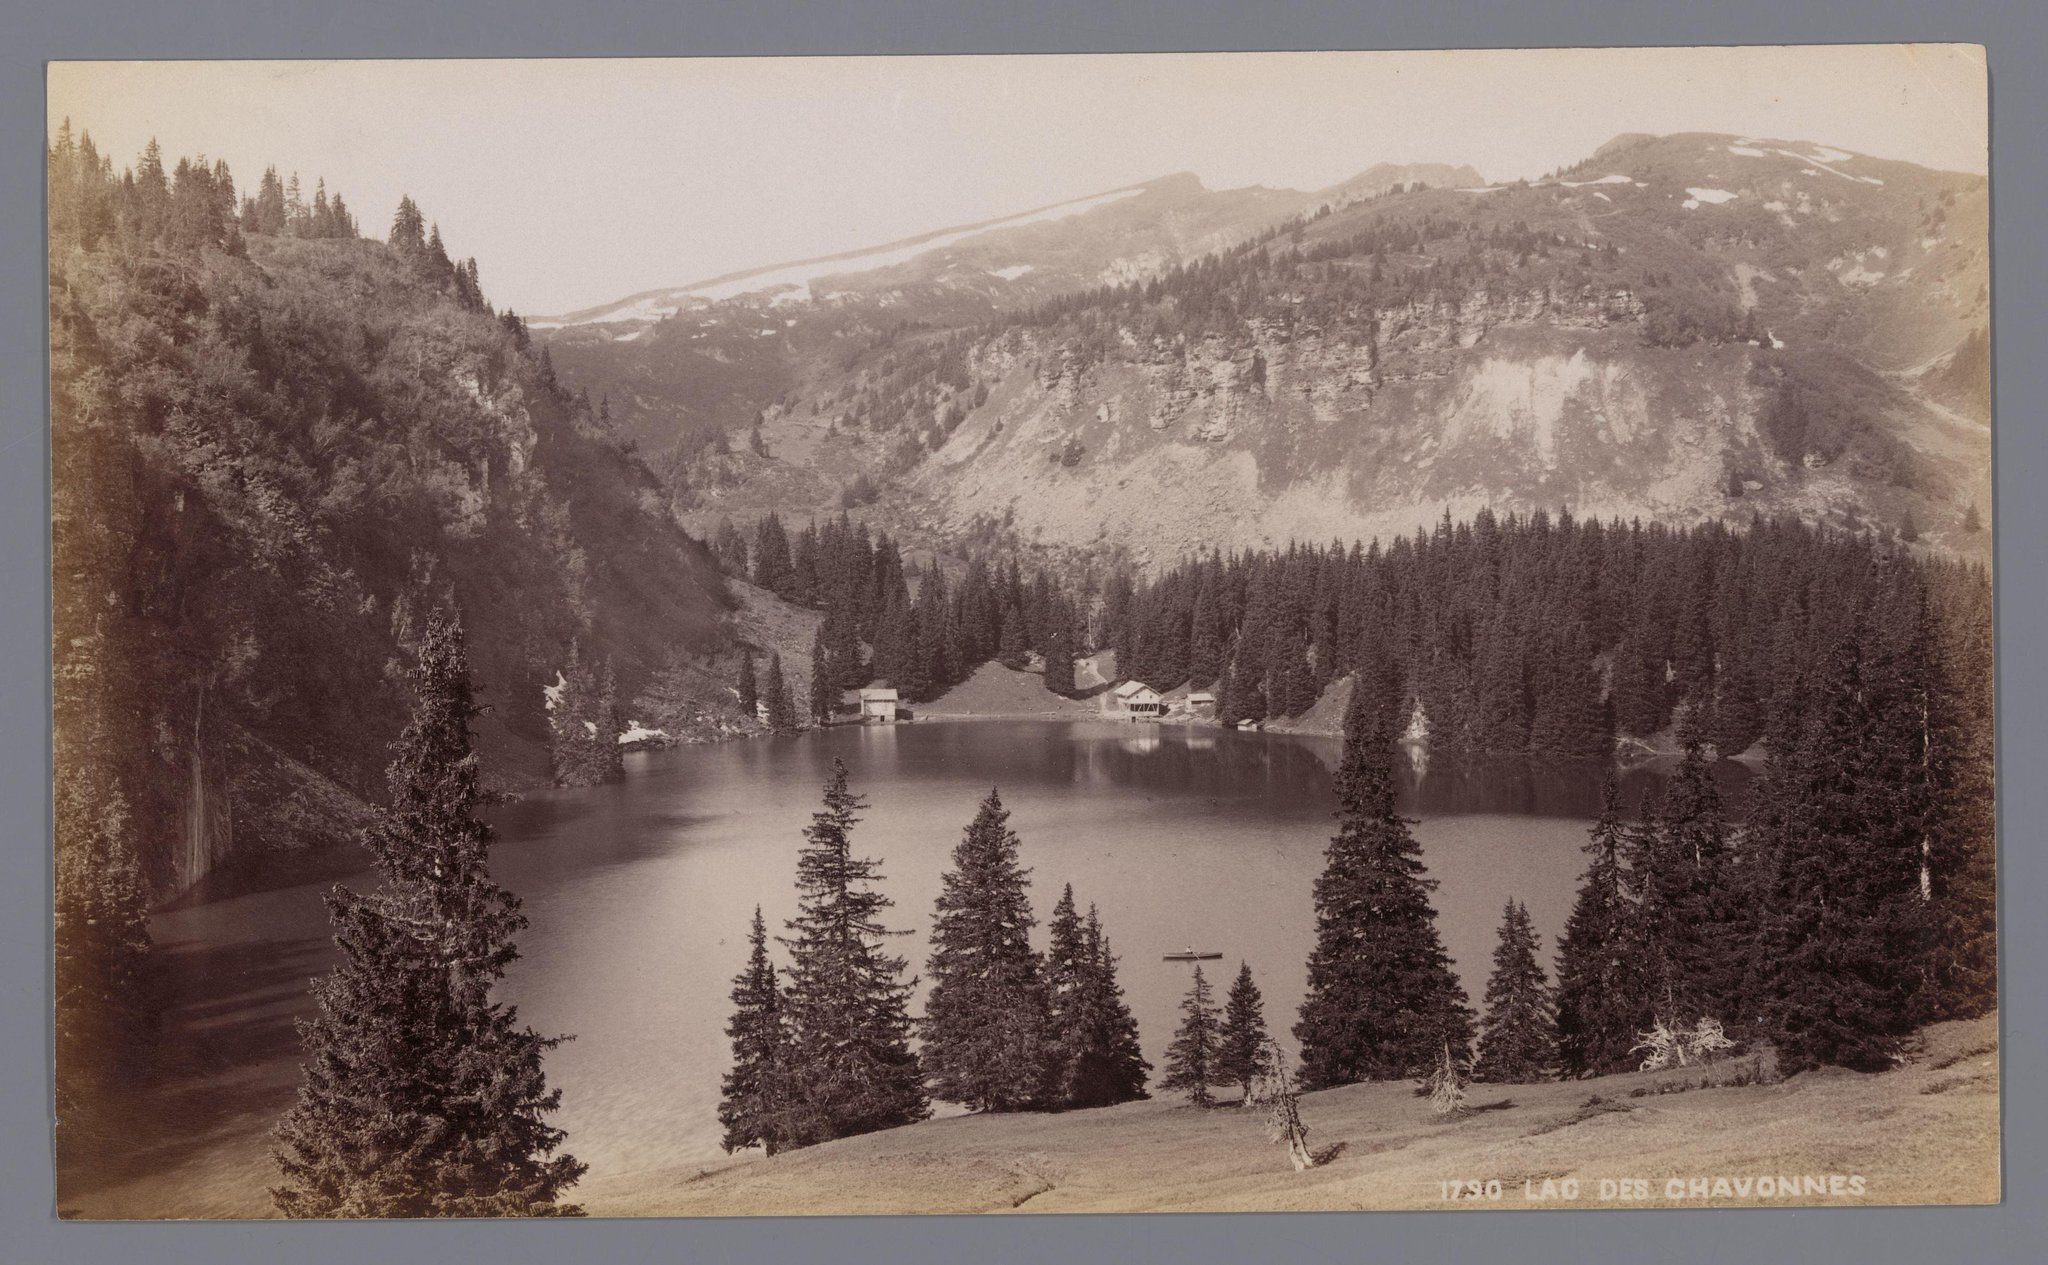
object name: photograph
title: Gezicht op het Lac des Chavonnes bij Villars-sur-Ollon in Vaud, Zwitserland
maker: Anonymous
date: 1900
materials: paper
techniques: albumen print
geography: villars-sur-ollon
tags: trees, lake, mountains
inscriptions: number: ‘1790’, collector's mark: ‘VOSMAER’